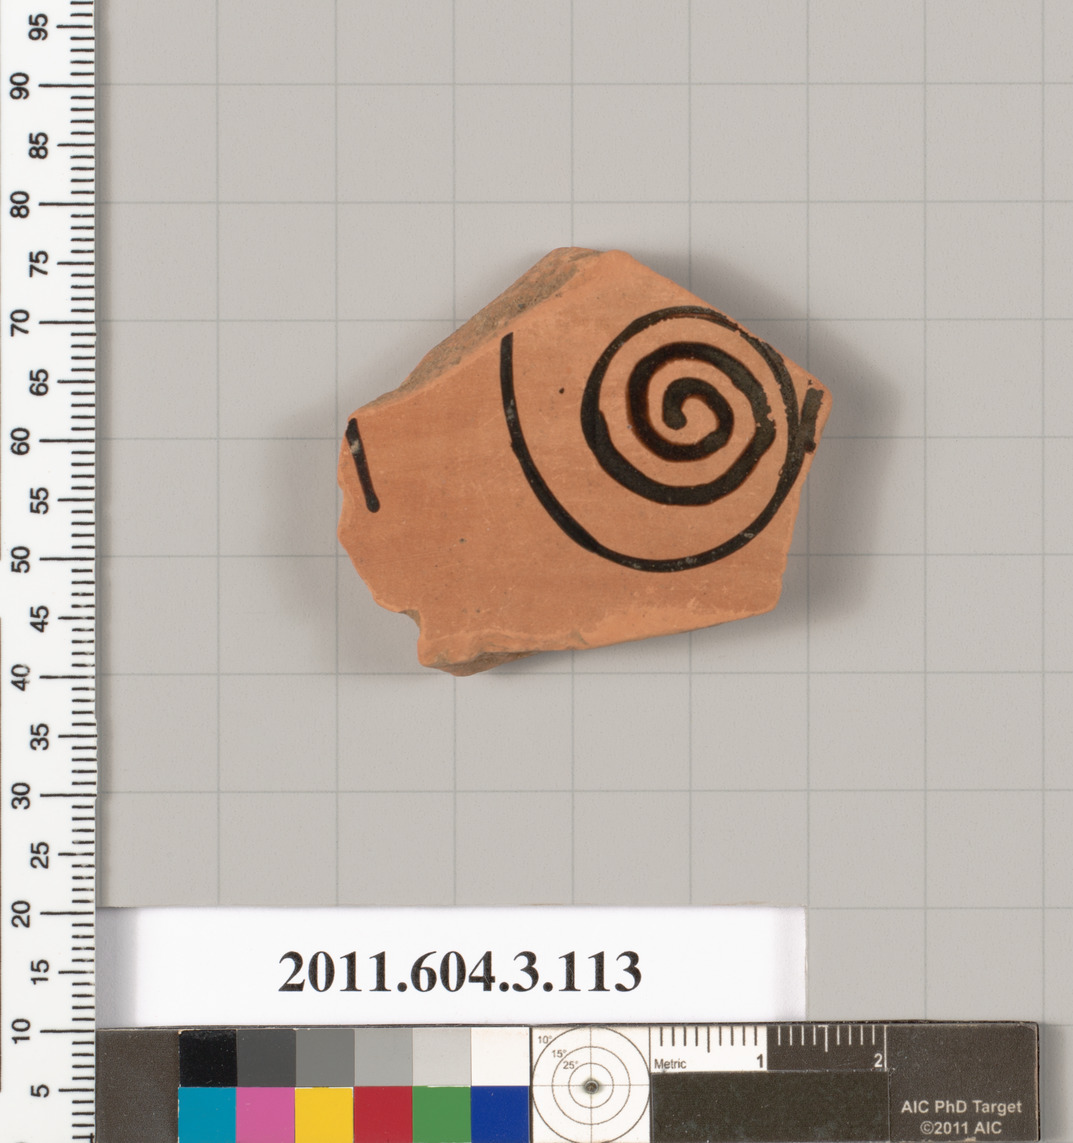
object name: amphora fragment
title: Terracotta fragment of an amphora (jar)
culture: greek, attic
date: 540-530 BCE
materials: terracotta